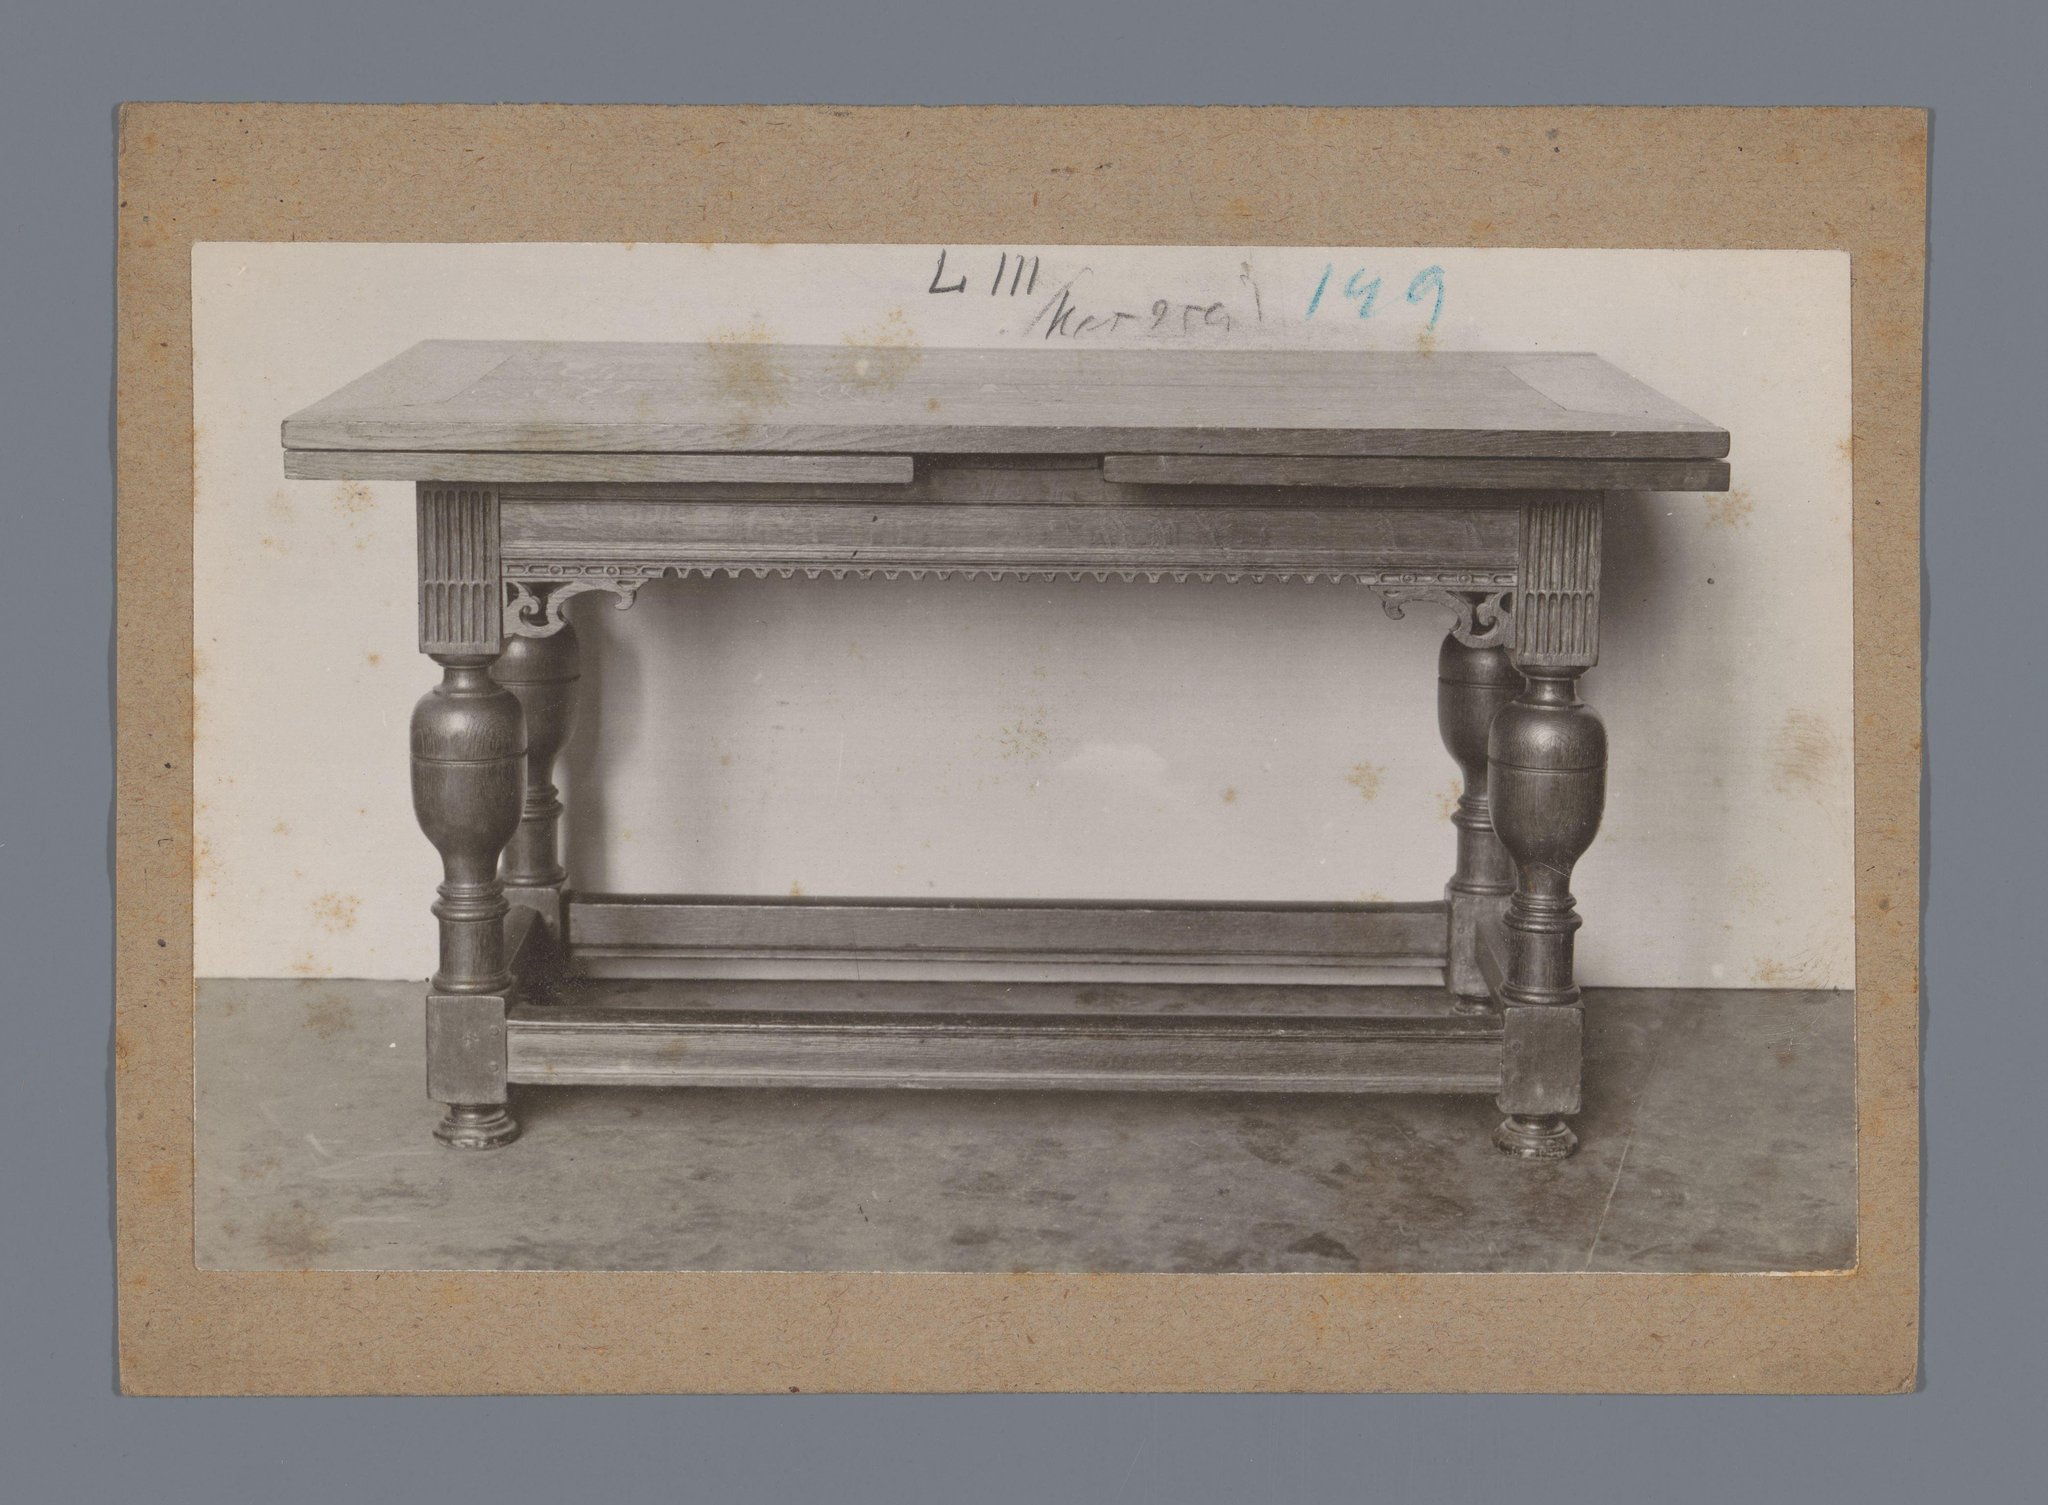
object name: photograph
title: Tafel (vermoedelijk) in het Rijksmuseum te Amsterdam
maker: Anonymous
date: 1875-1900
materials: photographic support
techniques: matte daylight collodion silver print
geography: amsterdam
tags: table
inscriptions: collector's mark: ‘Instituut voor kunst-nijverheidsonderwijs Gabriël Metsustraat No. 16, Amsterdam’, number: ‘LIII Kat 259 149’, collector's mark: ‘Kunstnijverheidschool Quellinus Amsterdam Frans Halsstraat 14.’